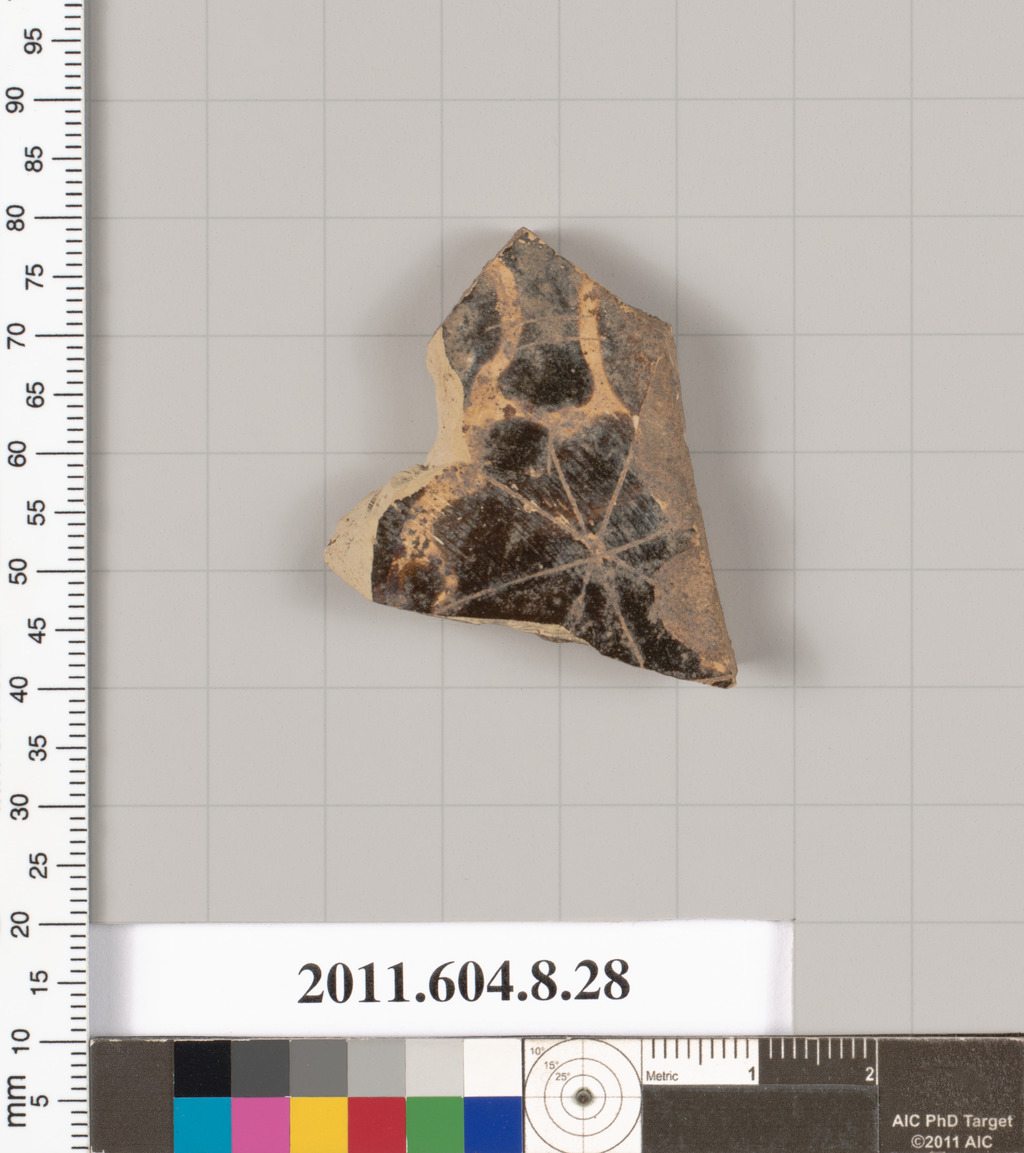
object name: undetermined closed shape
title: Terracotta fragment of a closed shape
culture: etruscan, etrusco-corinthian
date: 600-501 BCE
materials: terracotta